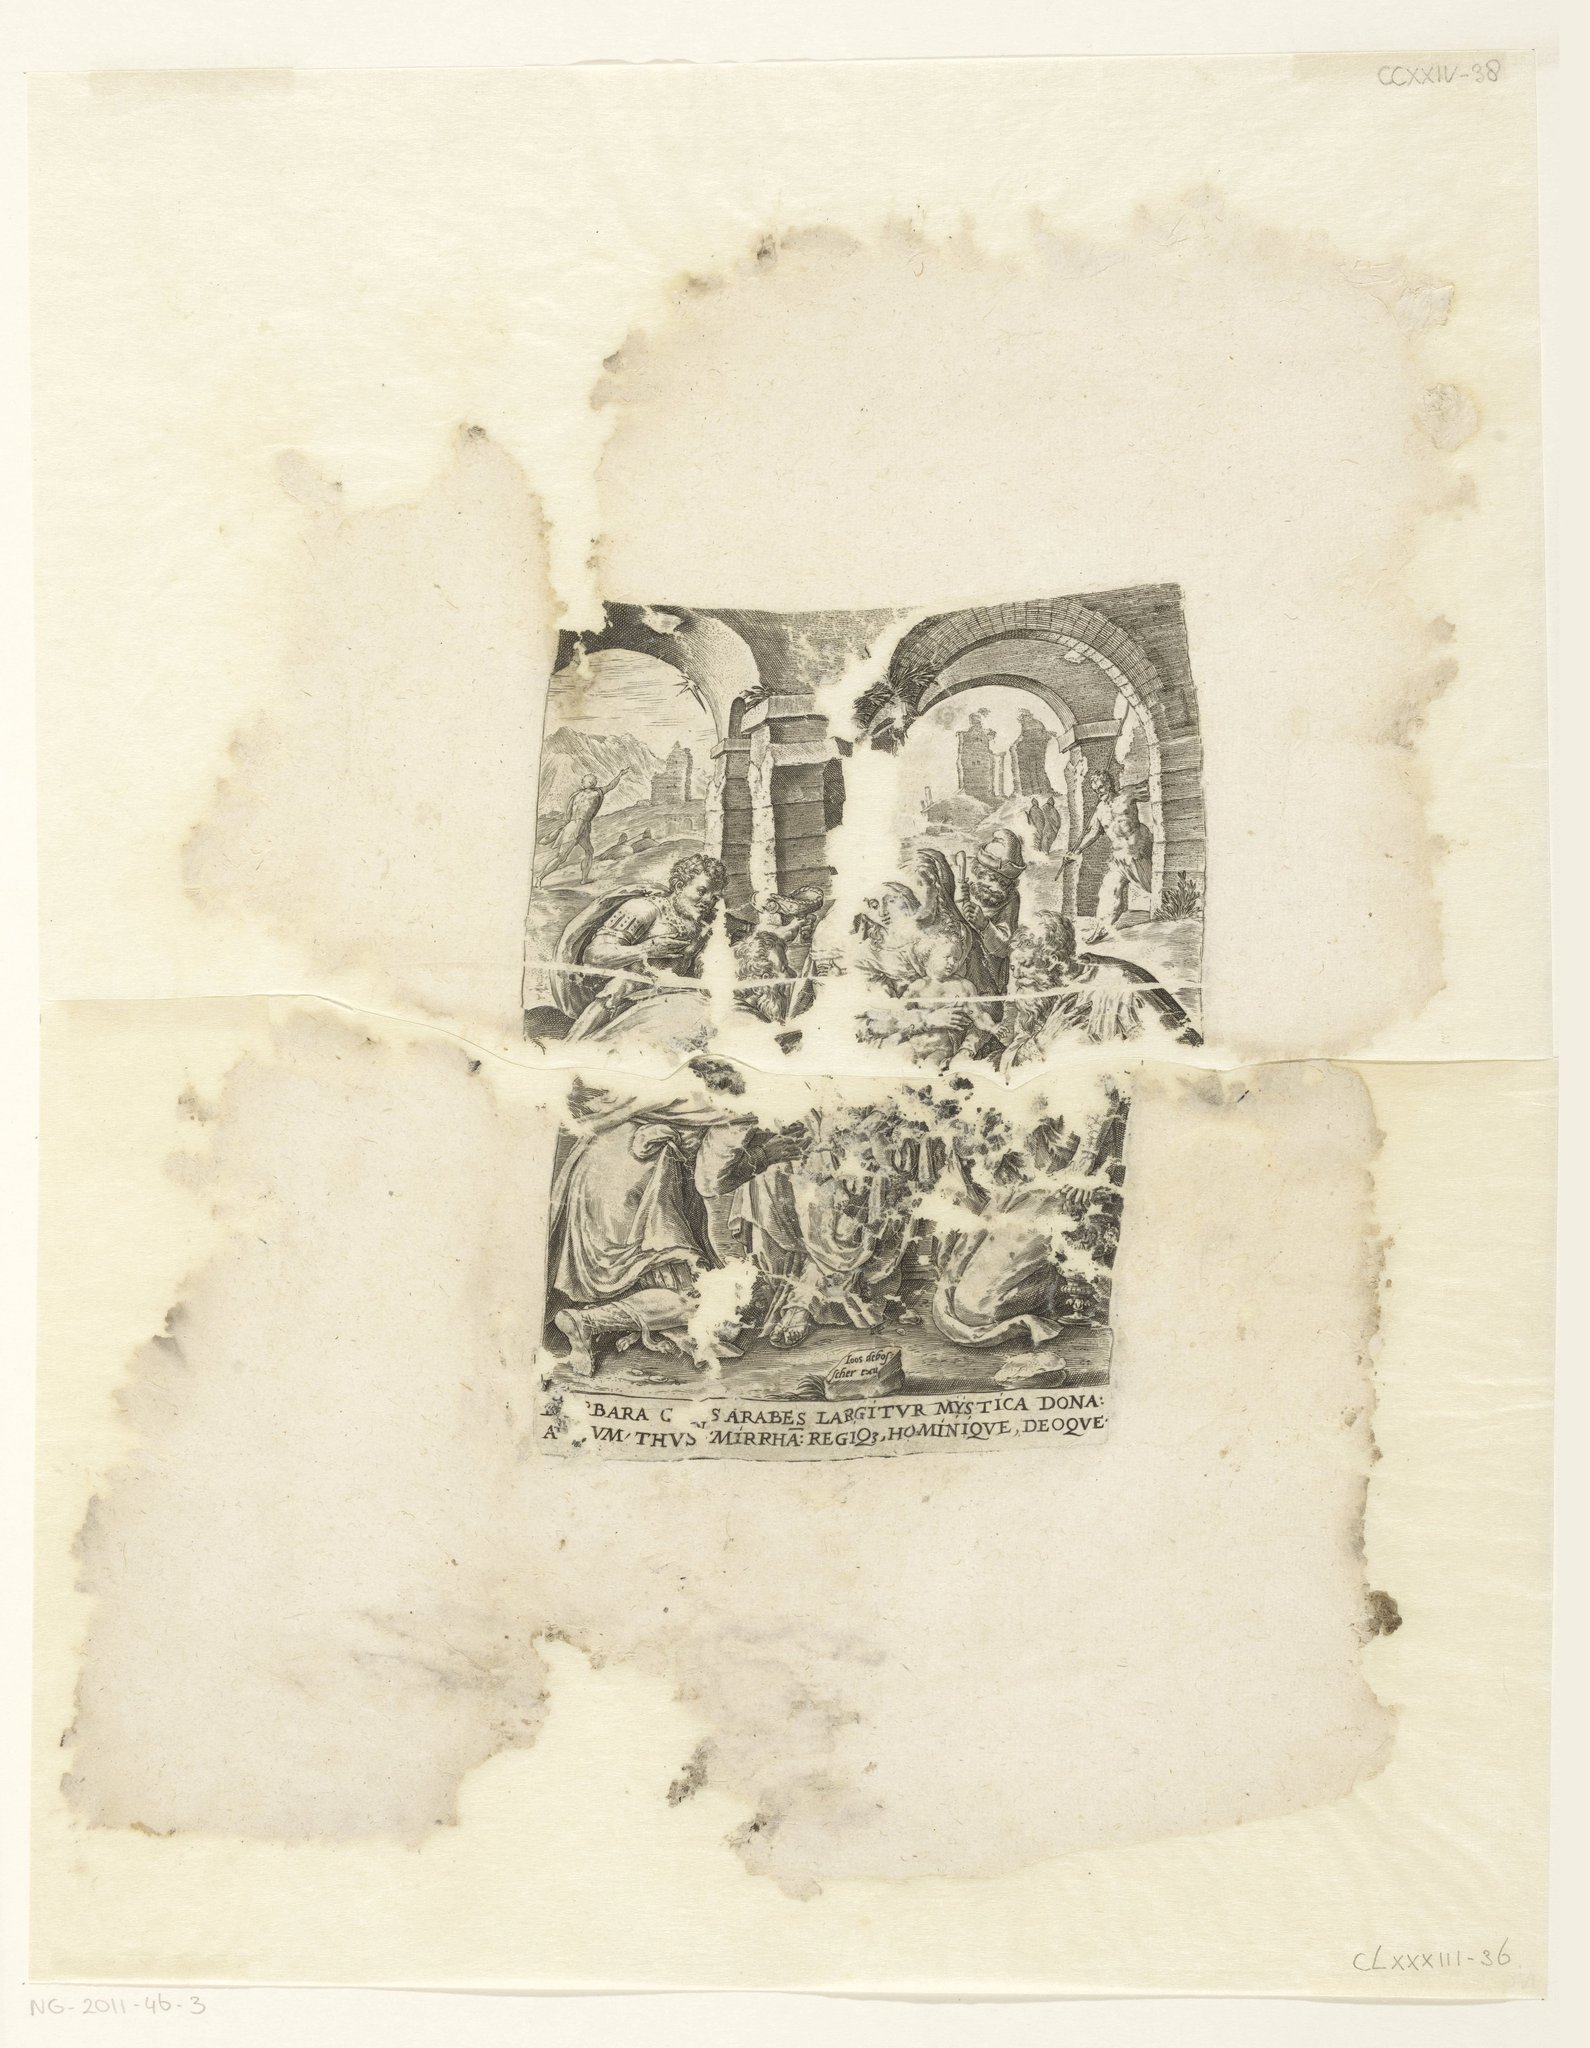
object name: print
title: Aanbidding door de koningen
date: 1570-1596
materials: paper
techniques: engraving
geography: southern netherlands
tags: adoration of the kings: the wise men present their gifts to the christ-child (gold, frankincense and myrrh)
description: Deze tot dusver onbekende door Joos de Bosscher uitgegeven prent kan nog tot diens Antwerpse uitgaven behoren. De prenten in de Nova Zembla collectie zijn tijdens een expeditie van Willem Barendsz en Jacob van Heemskerk in 1596-1597 noodgedwongen in het winterkamp, het ‘Behouden Huis’, op het eiland achtergelaten. De prenten waren in één of meerdere stapels als handelswaar meegenomen vanuit Amsterdam. Bijna drie eeuwen later, in 1871, keerde de Noor Elling Carlsen terug naar Nova Zembla en vond daar de restanten van het ‘Behouden Huis, inclusief een groot deel van de inventaris. Een deel van de prenten, in de vorm van aaneengekoekte kluiten, werd toen ook teruggevonden. De papierkluiten waren soms op meerdere plekken gebroken. Tussen 1975-1979 zijn de prenten van elkaar gescheiden. Dit leverde in totaal ca. 1000 fragmenten van ca. 400 afdrukken van ca. 150 verschillende prenten op. Voor zover mogelijk zijn de fragmenten samengevoegd en zijn de prenten gereconstrueerd.